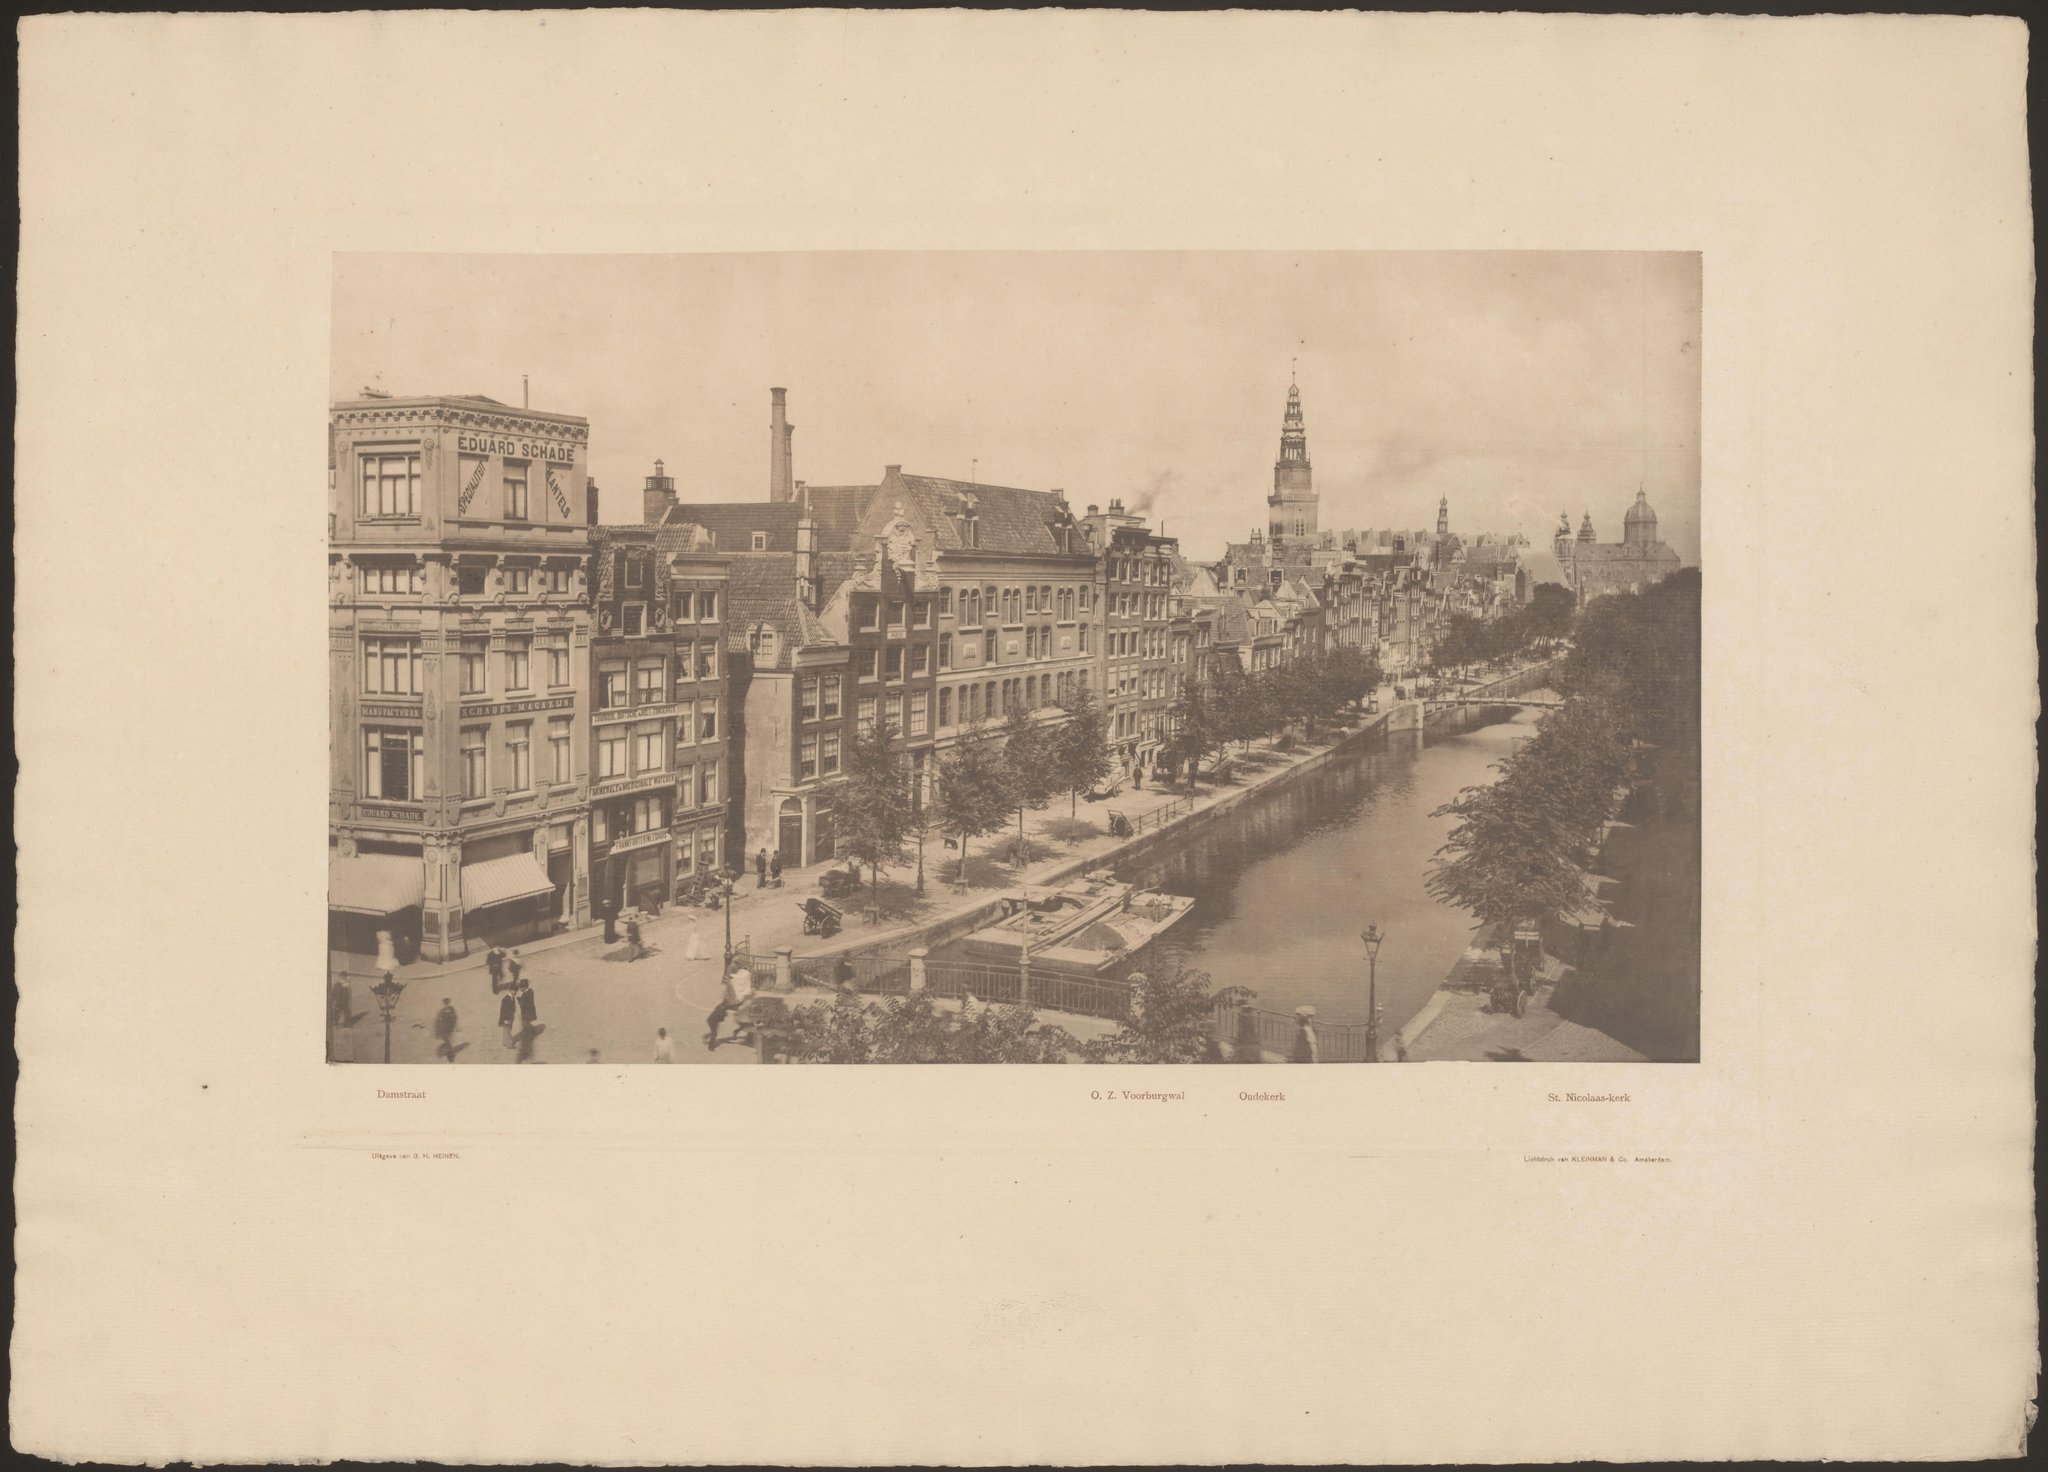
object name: photomechanical print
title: Gezicht op de Oudezijds Voorburgwal richting de Oude Kerk en de Basiliek van de Heilige Nicolaas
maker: gerrit hendricus heinen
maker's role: painter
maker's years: 1851-1930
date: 1892-1930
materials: paper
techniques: photograph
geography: amsterdam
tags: tower, clock tower ~ monumental adornment, canal, church (exterior), bridge in city across river, canal, etc., street, prospect of city, town panorama, silhouette of city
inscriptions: check stamp: ‘G.H. Heinen Amsterdam / Schilder & Fotograaf’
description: Onderwerpsrubriek binnen de Atlas Amsterdam: Panorama's en verzamelprenten.